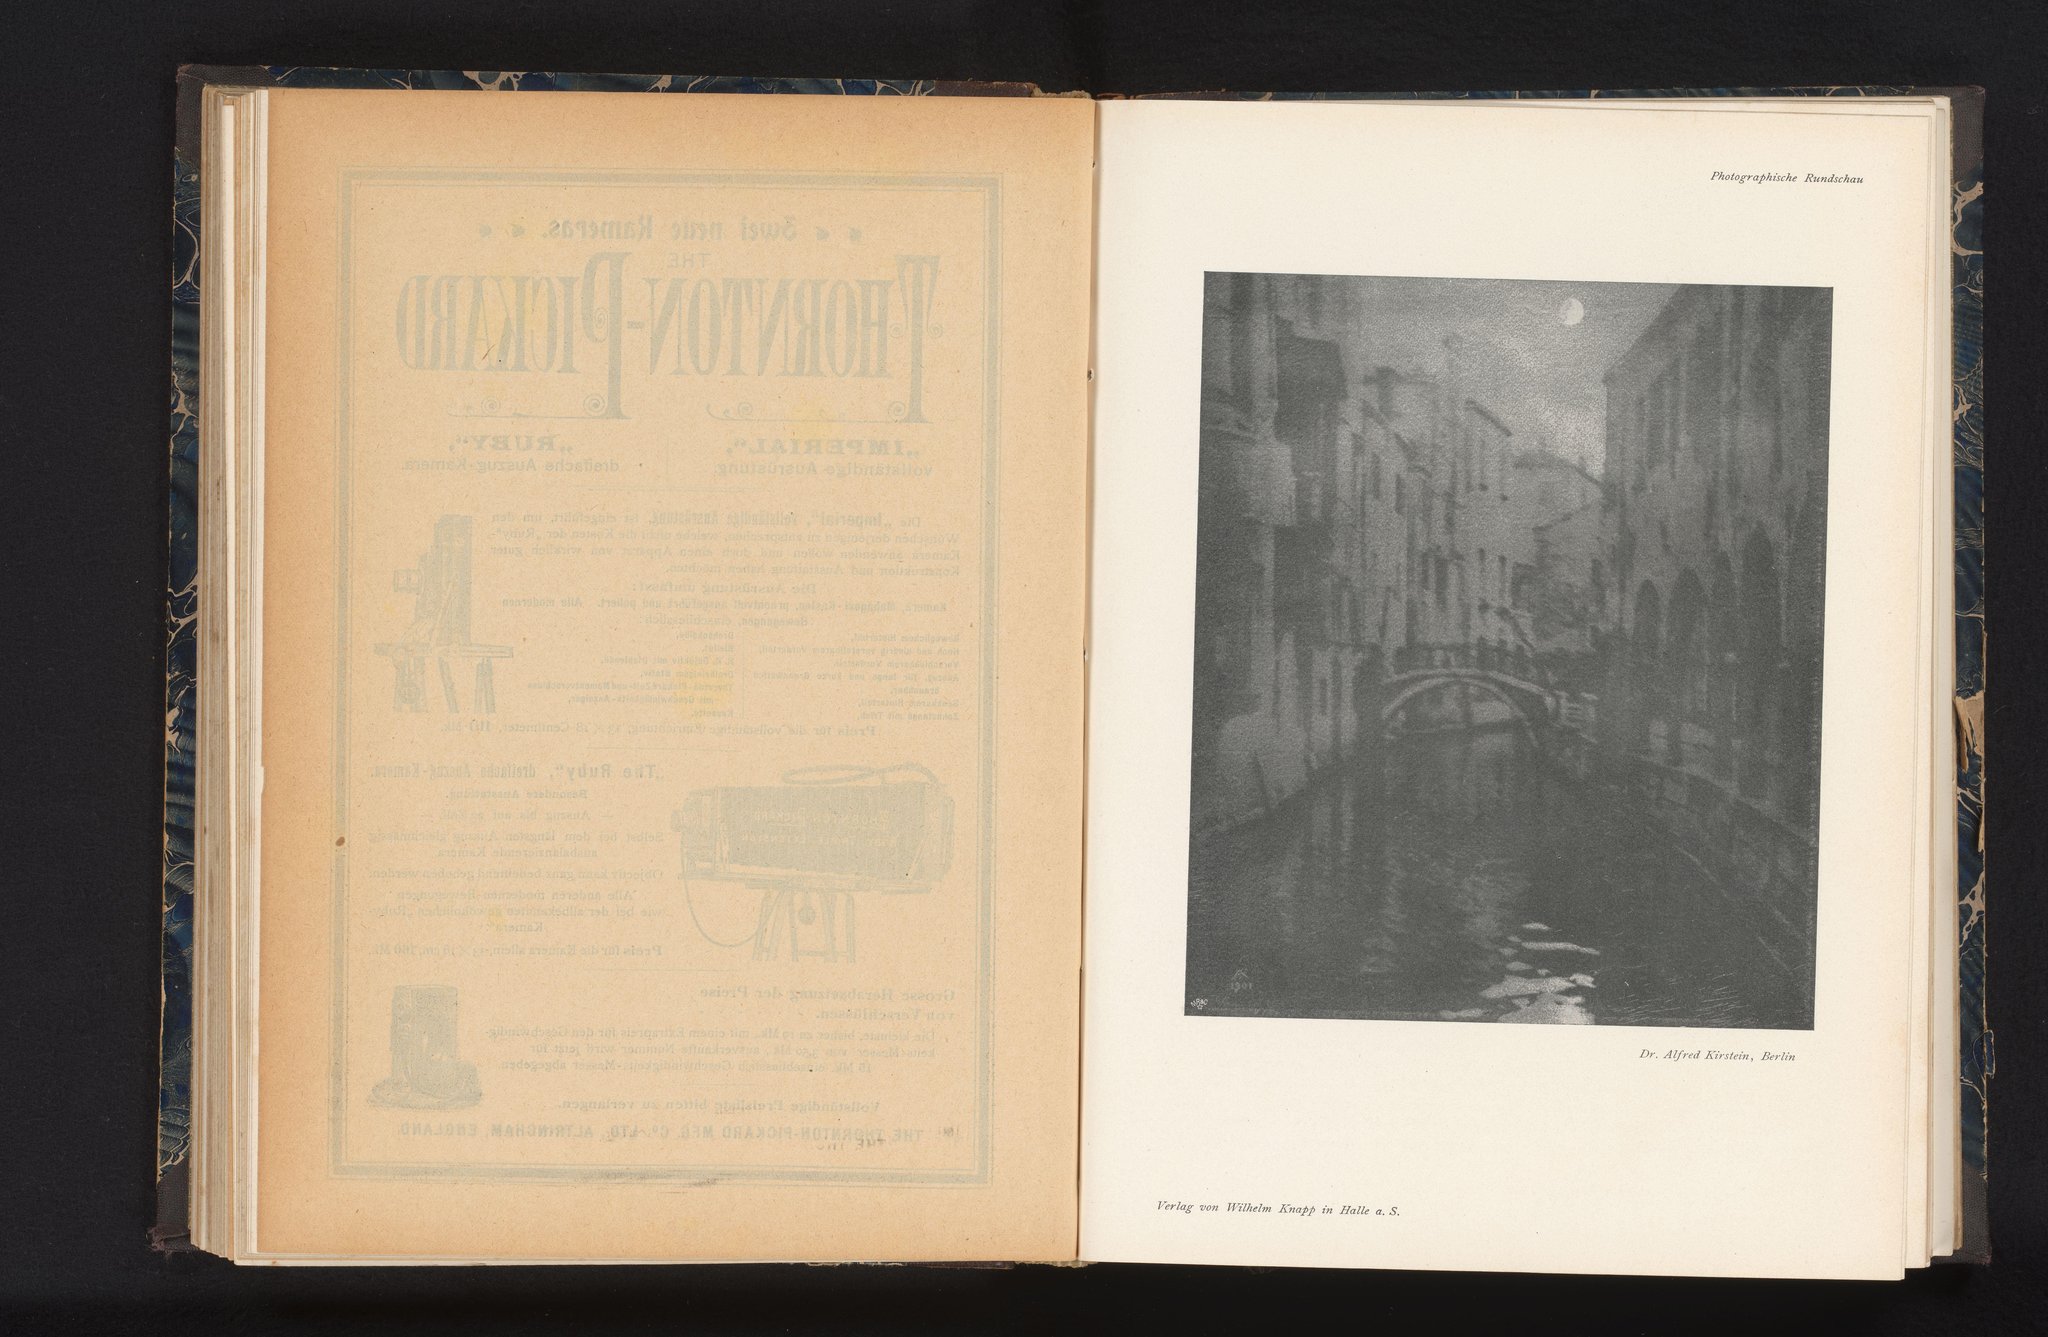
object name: page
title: Gezicht op een gracht of kanaal en een brug, vermoedelijk in Venetië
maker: alfred kirstein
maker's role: painter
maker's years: 1863-1922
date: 1897-1902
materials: paper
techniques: autotype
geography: halle an der saale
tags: city-view in general; 'veduta', canals, waters (in city), bridge